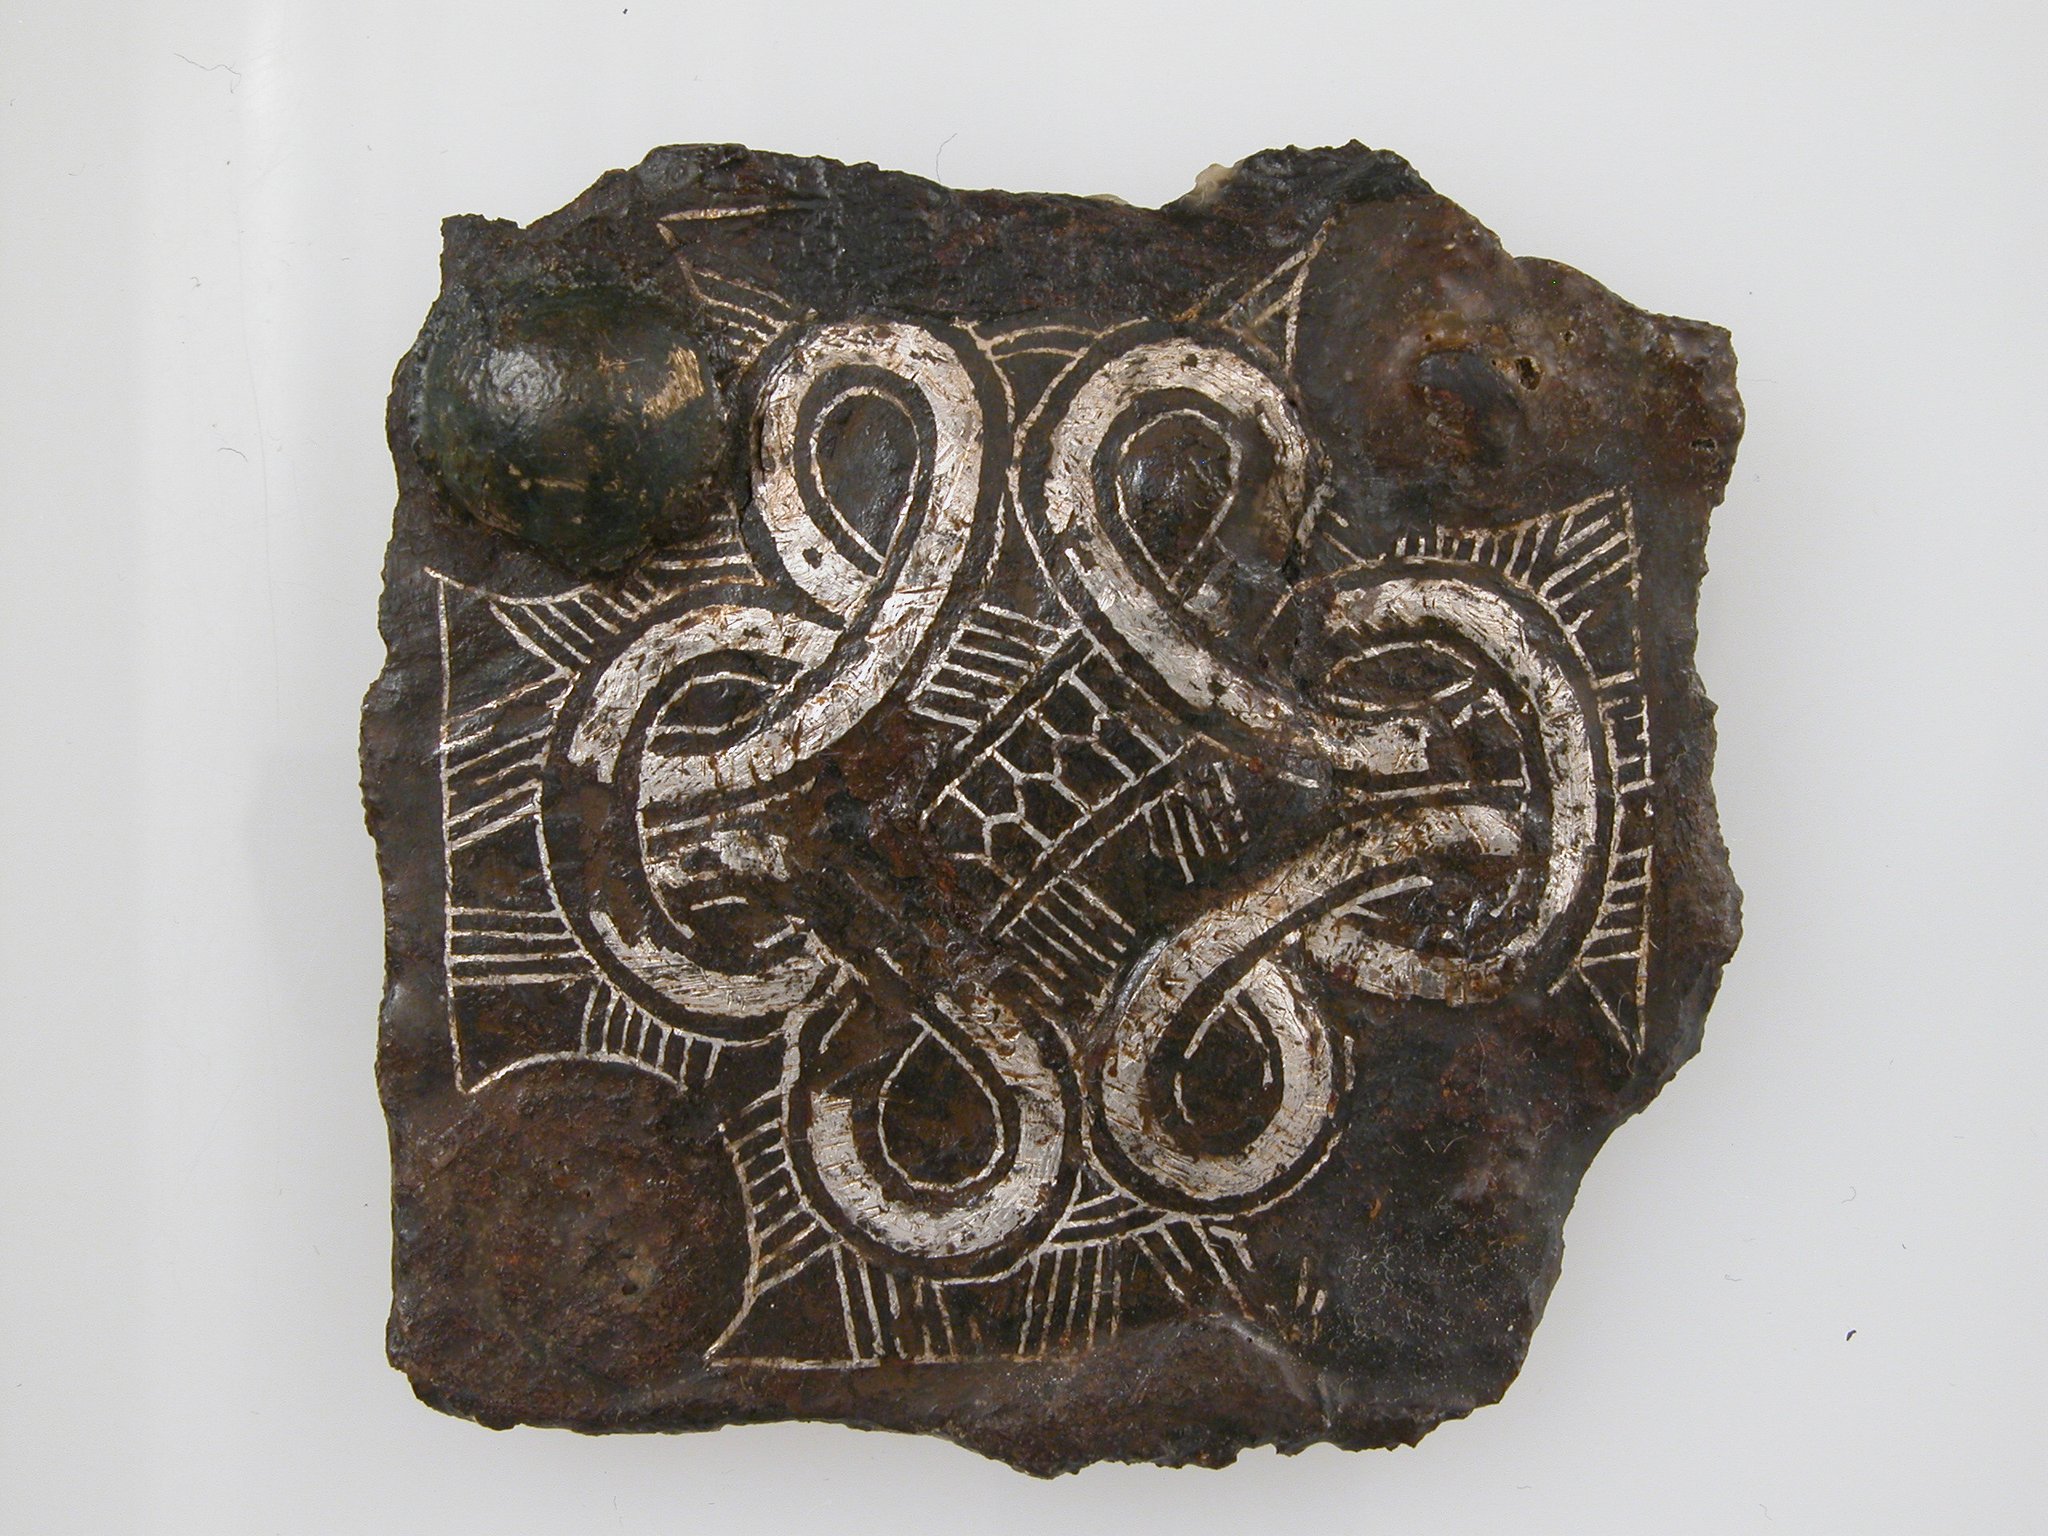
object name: belt plate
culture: frankish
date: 301-700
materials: gilt bronze, iron, silver